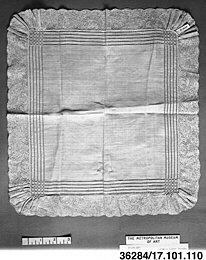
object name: handkerchief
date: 1601-1800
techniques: lace